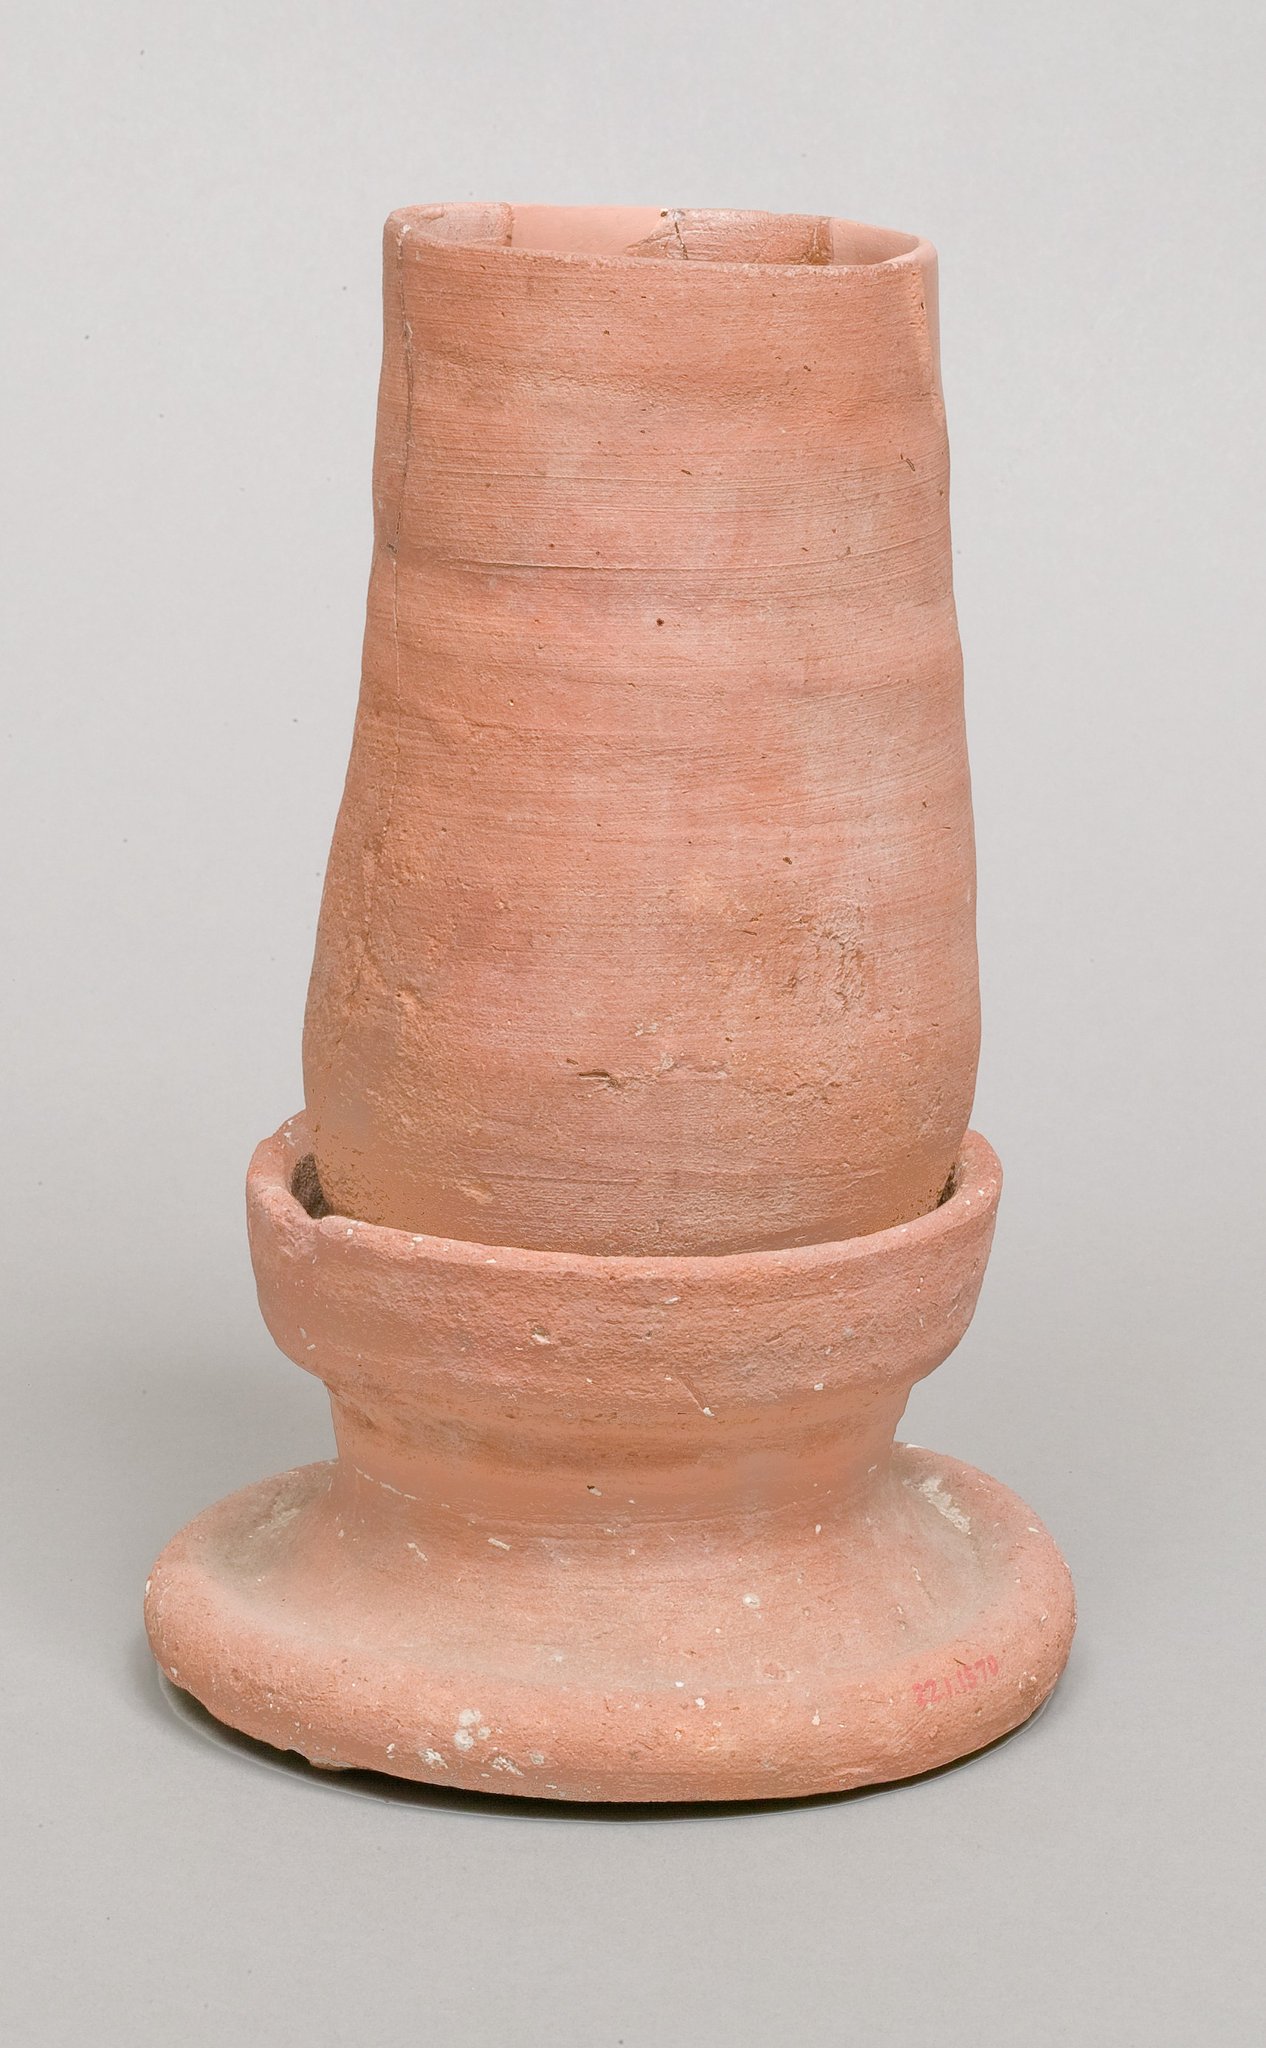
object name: pot stand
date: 1981-1640 BCE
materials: pottery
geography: egypt